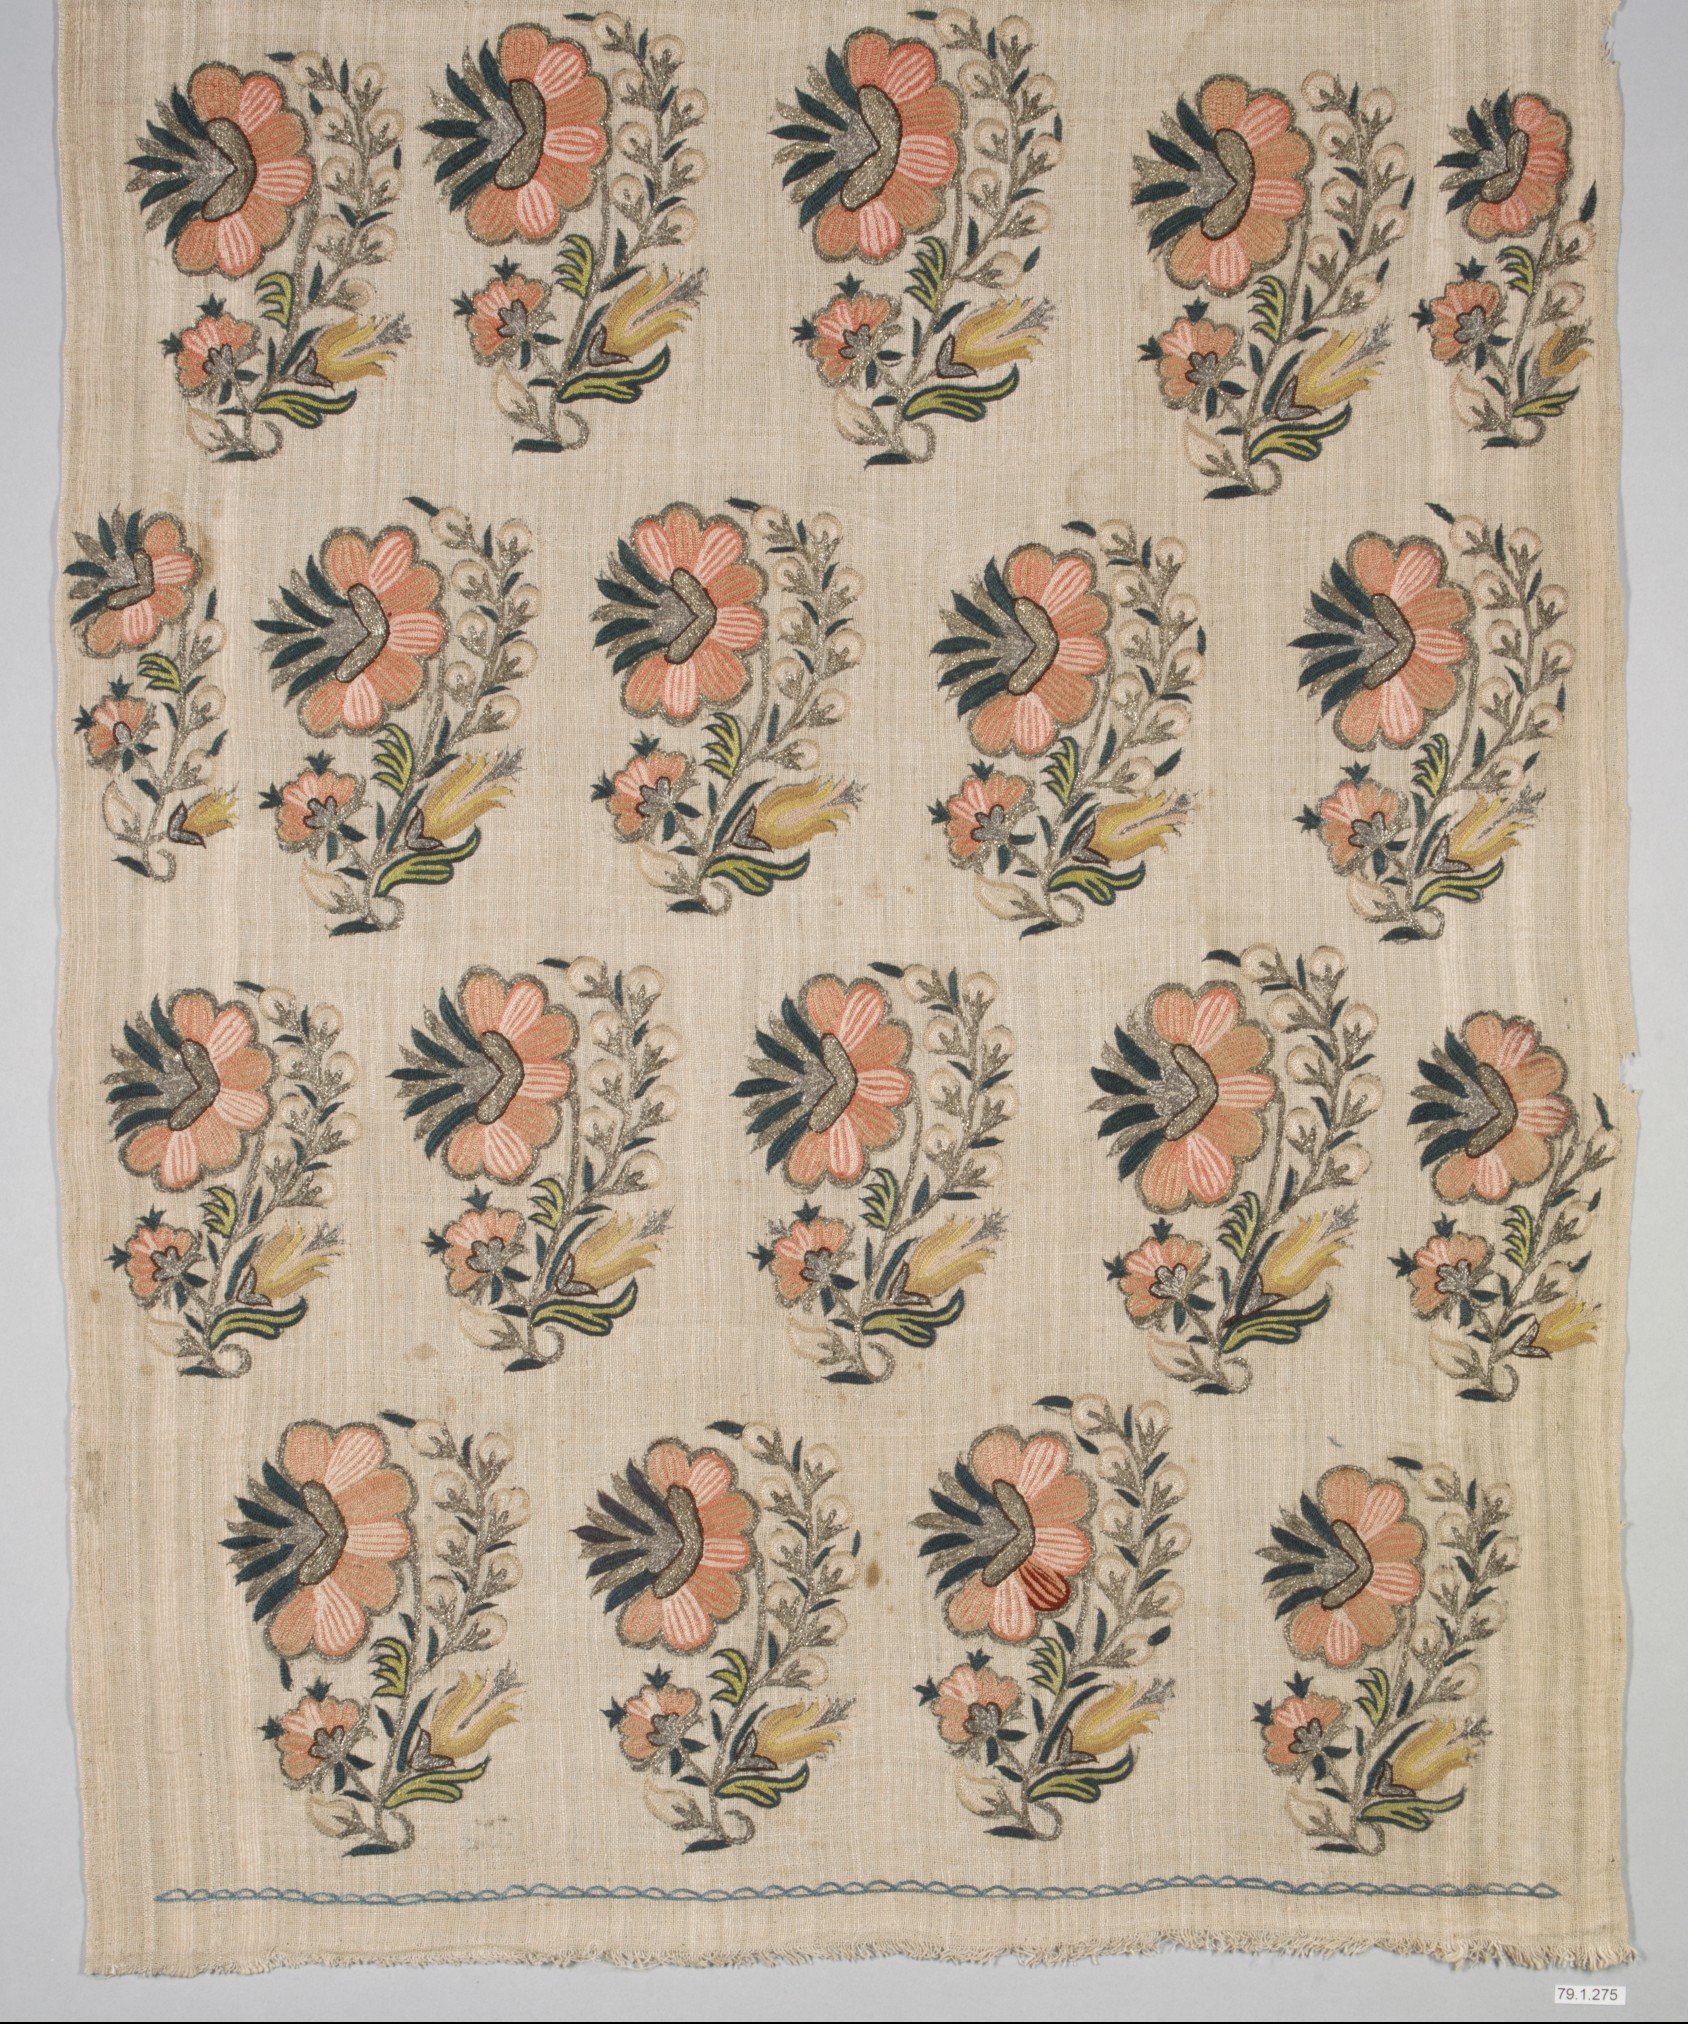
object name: towel end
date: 1801-1833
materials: linen, metal thread, silk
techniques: embroidery, weave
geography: turkey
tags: flowers